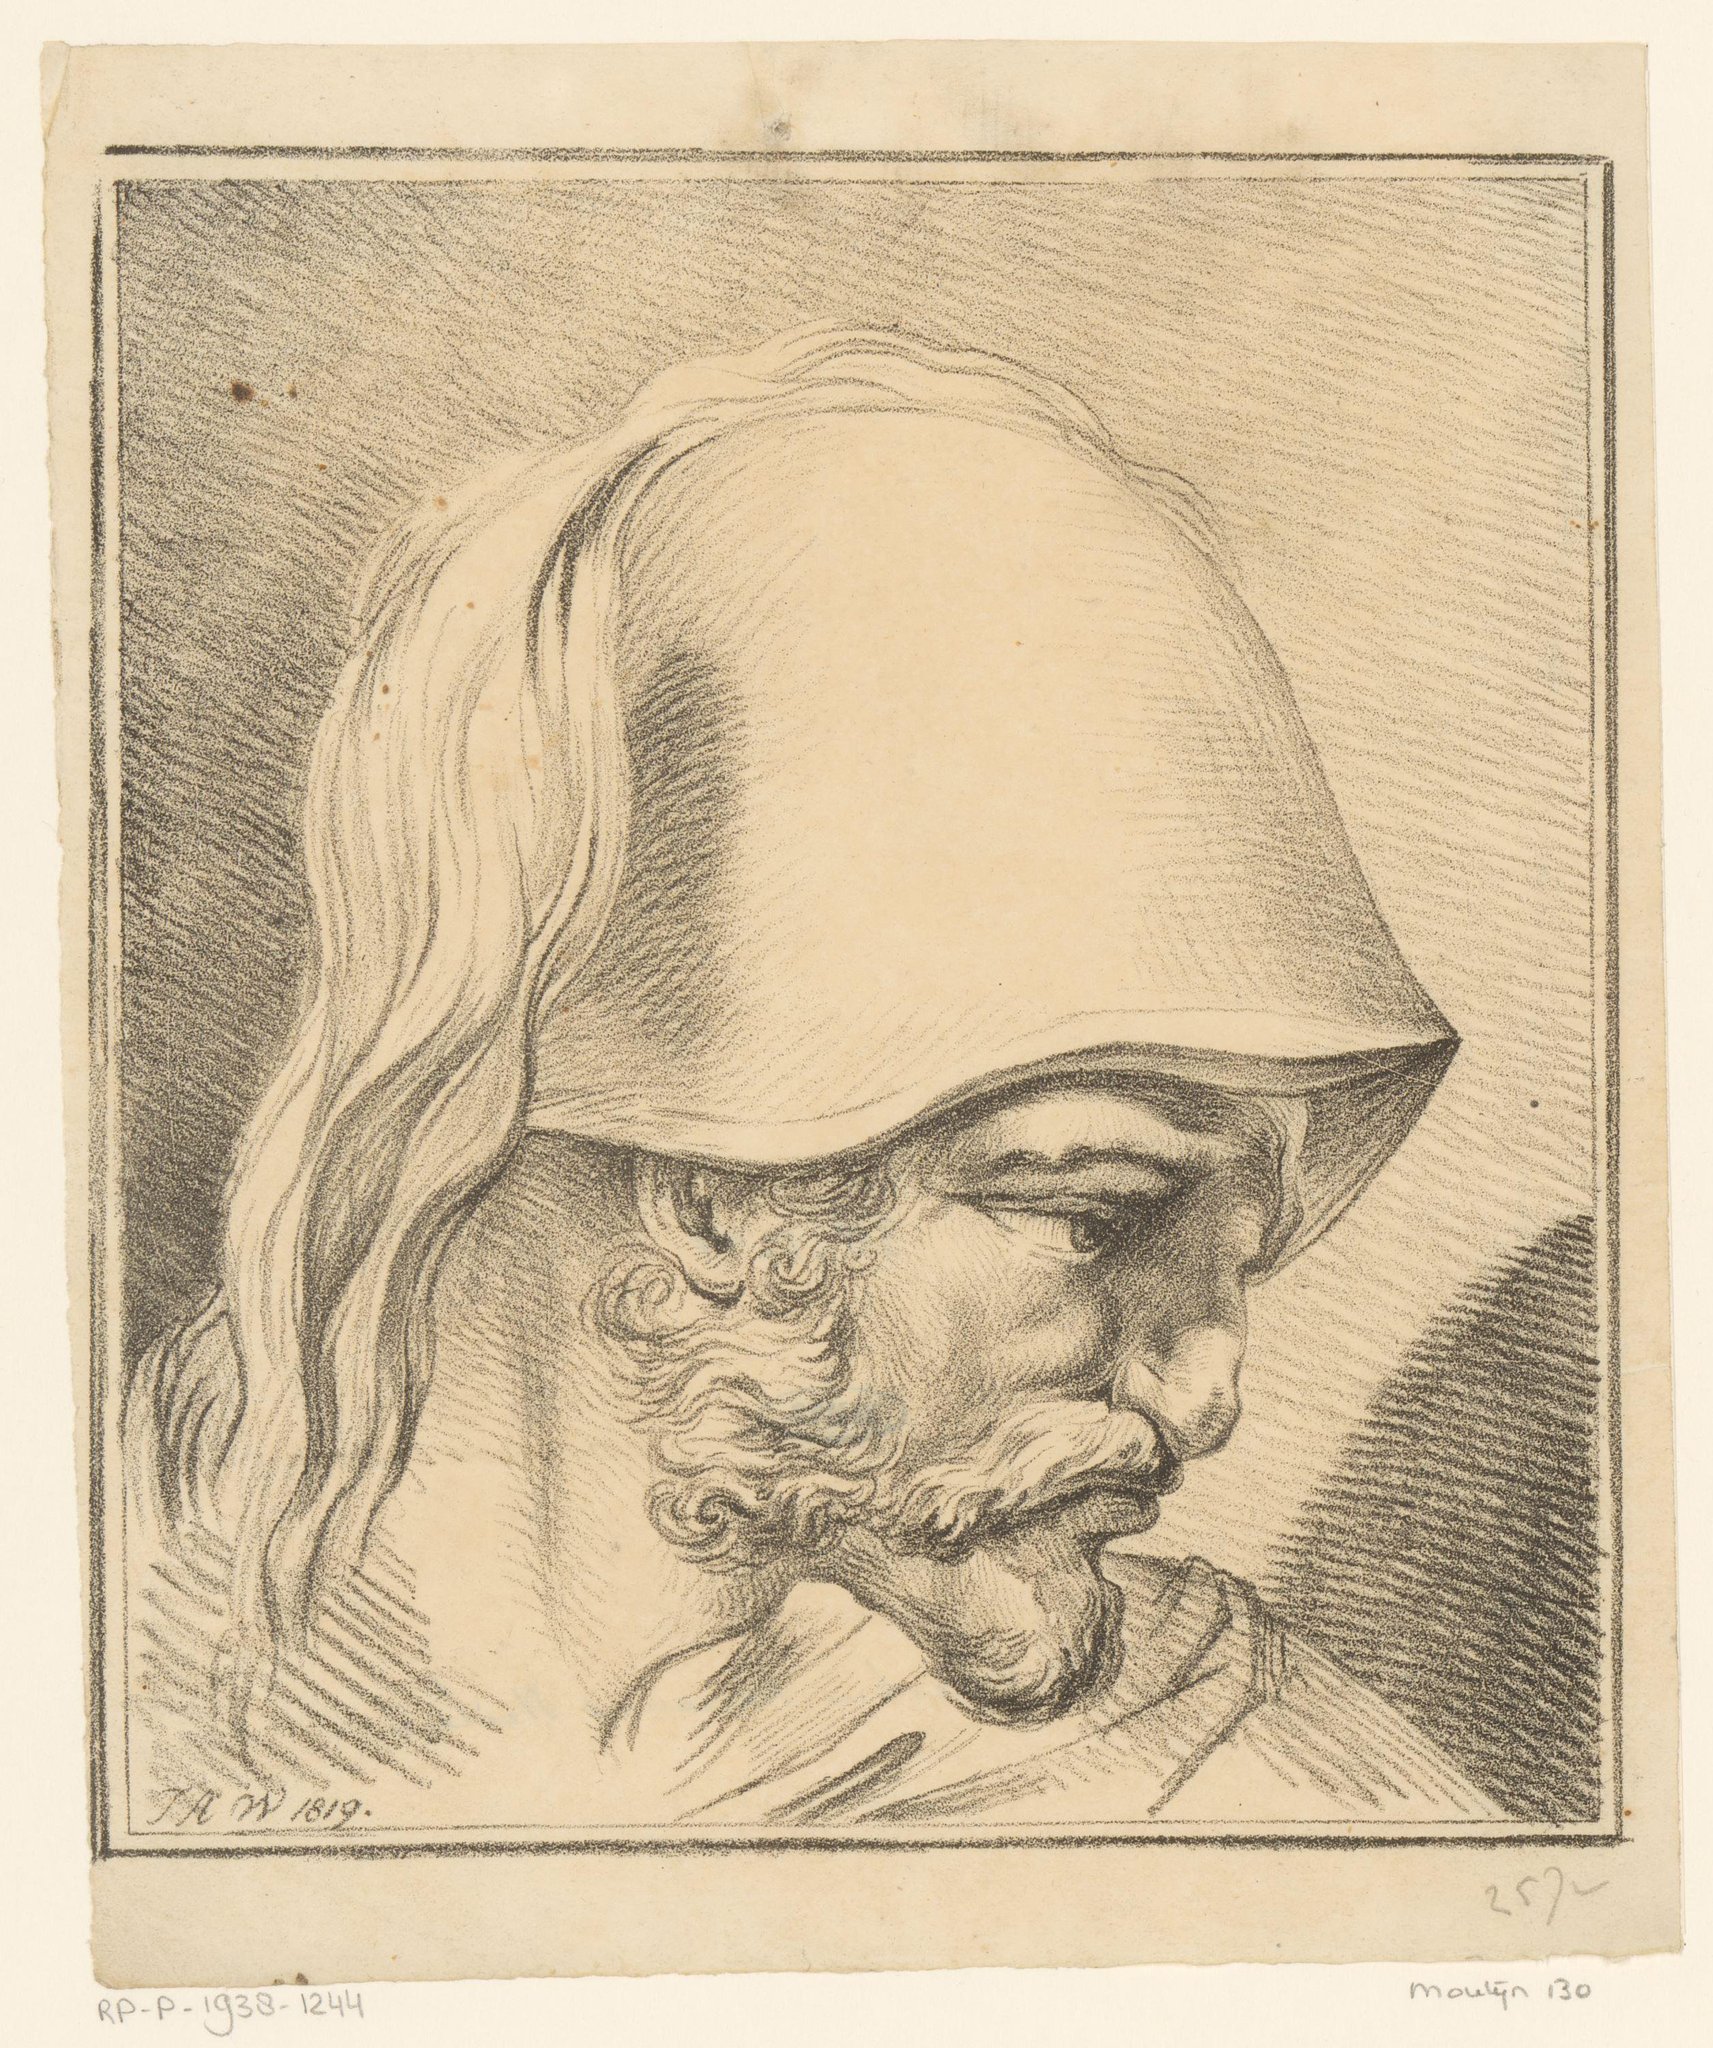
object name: print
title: Man met helm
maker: jacobus adrianus weiland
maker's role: print maker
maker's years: 1784-1869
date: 1819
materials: paper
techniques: lithograph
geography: netherlands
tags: adult man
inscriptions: collector's mark: Lugt 2228, collector's mark: Lugt 2760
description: Man met helm met veren naar rechts onder kijkend.